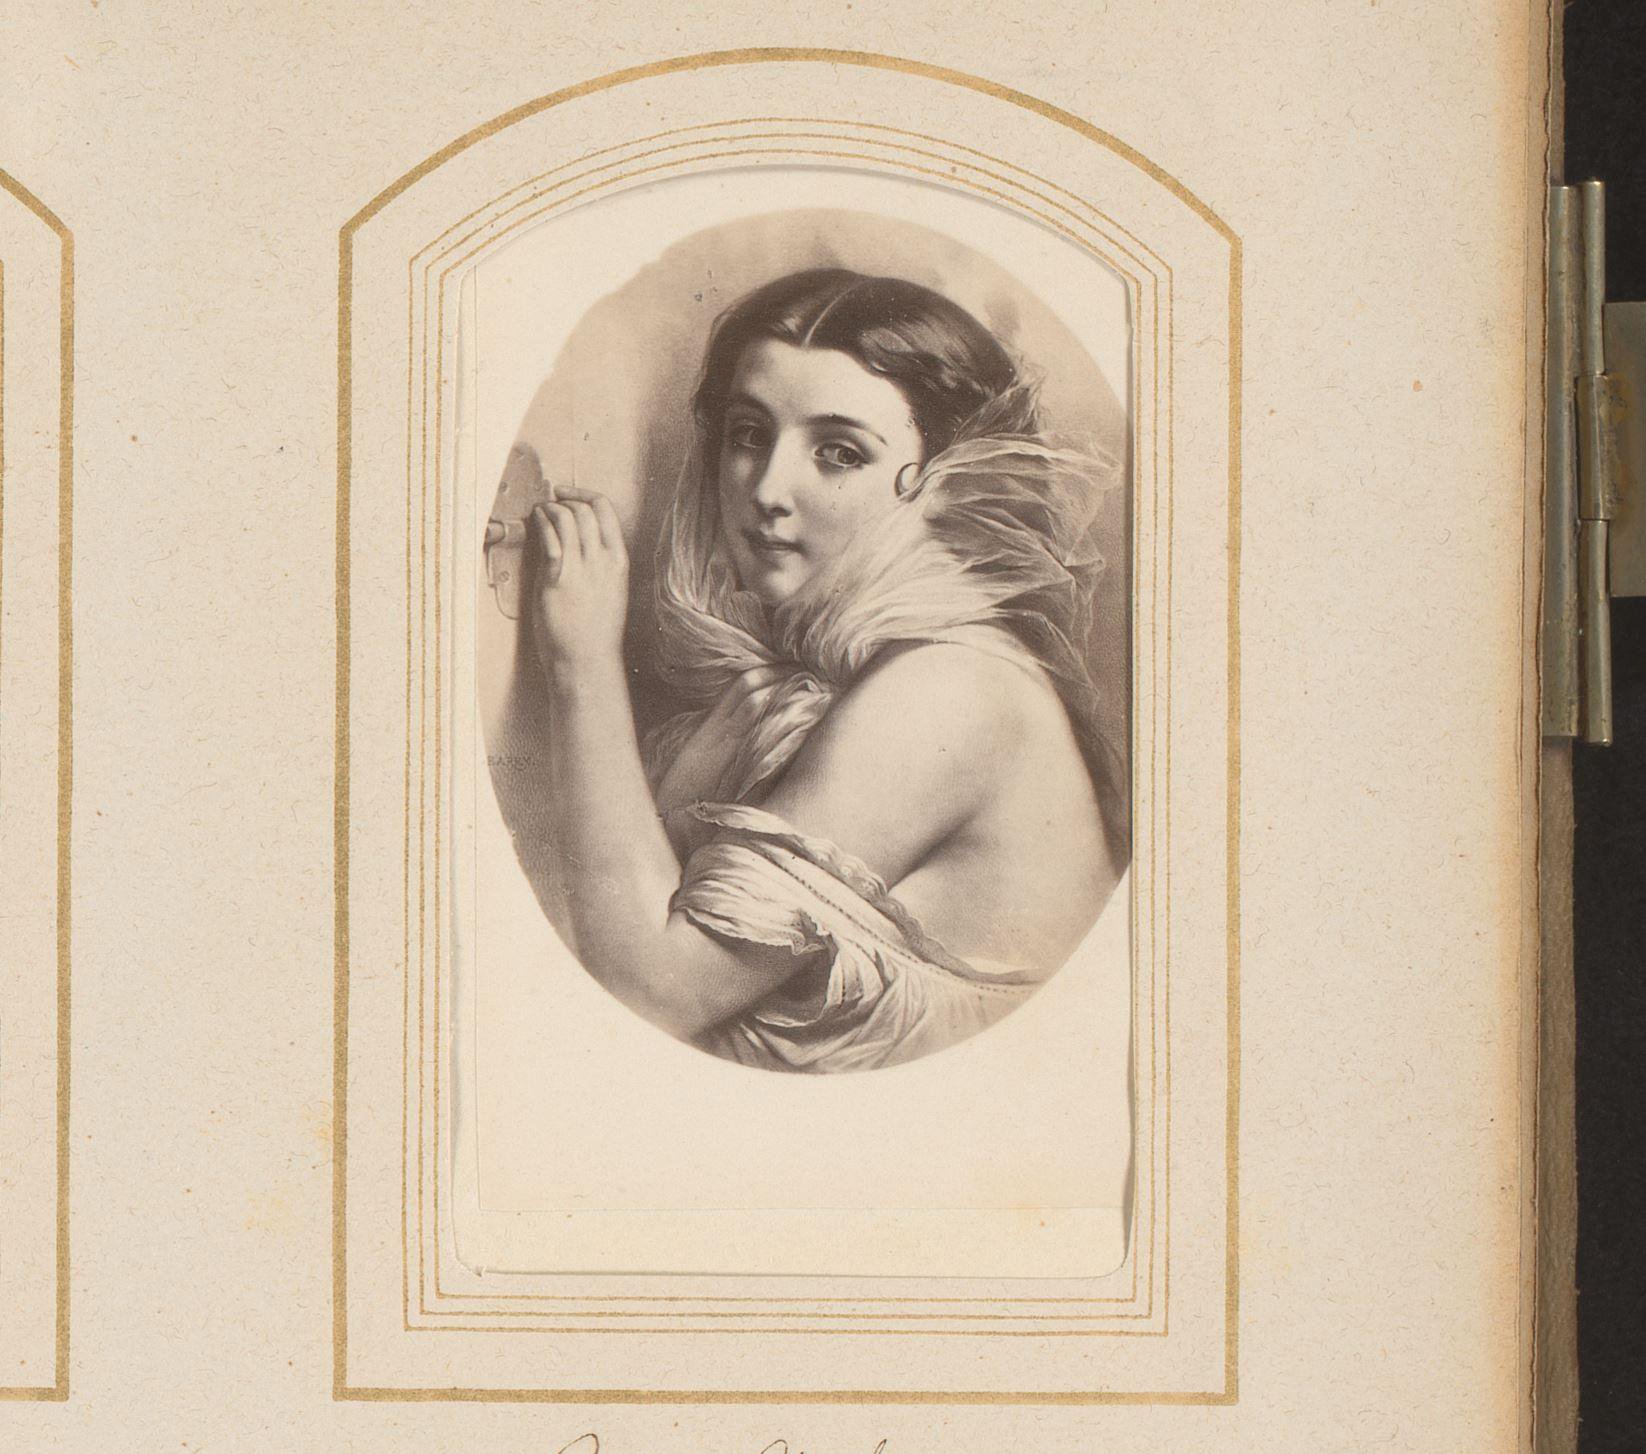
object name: album leaf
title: Fotoreproductie van Am Abend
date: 1870-1890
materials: cardboard, photographic support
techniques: albumen print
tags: lock ~ door, adult woman, painting, drawing and the graphic arts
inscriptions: annotation: ‘Am Abend’, inscription: ‘Brochart/ 1518, Am Abend’